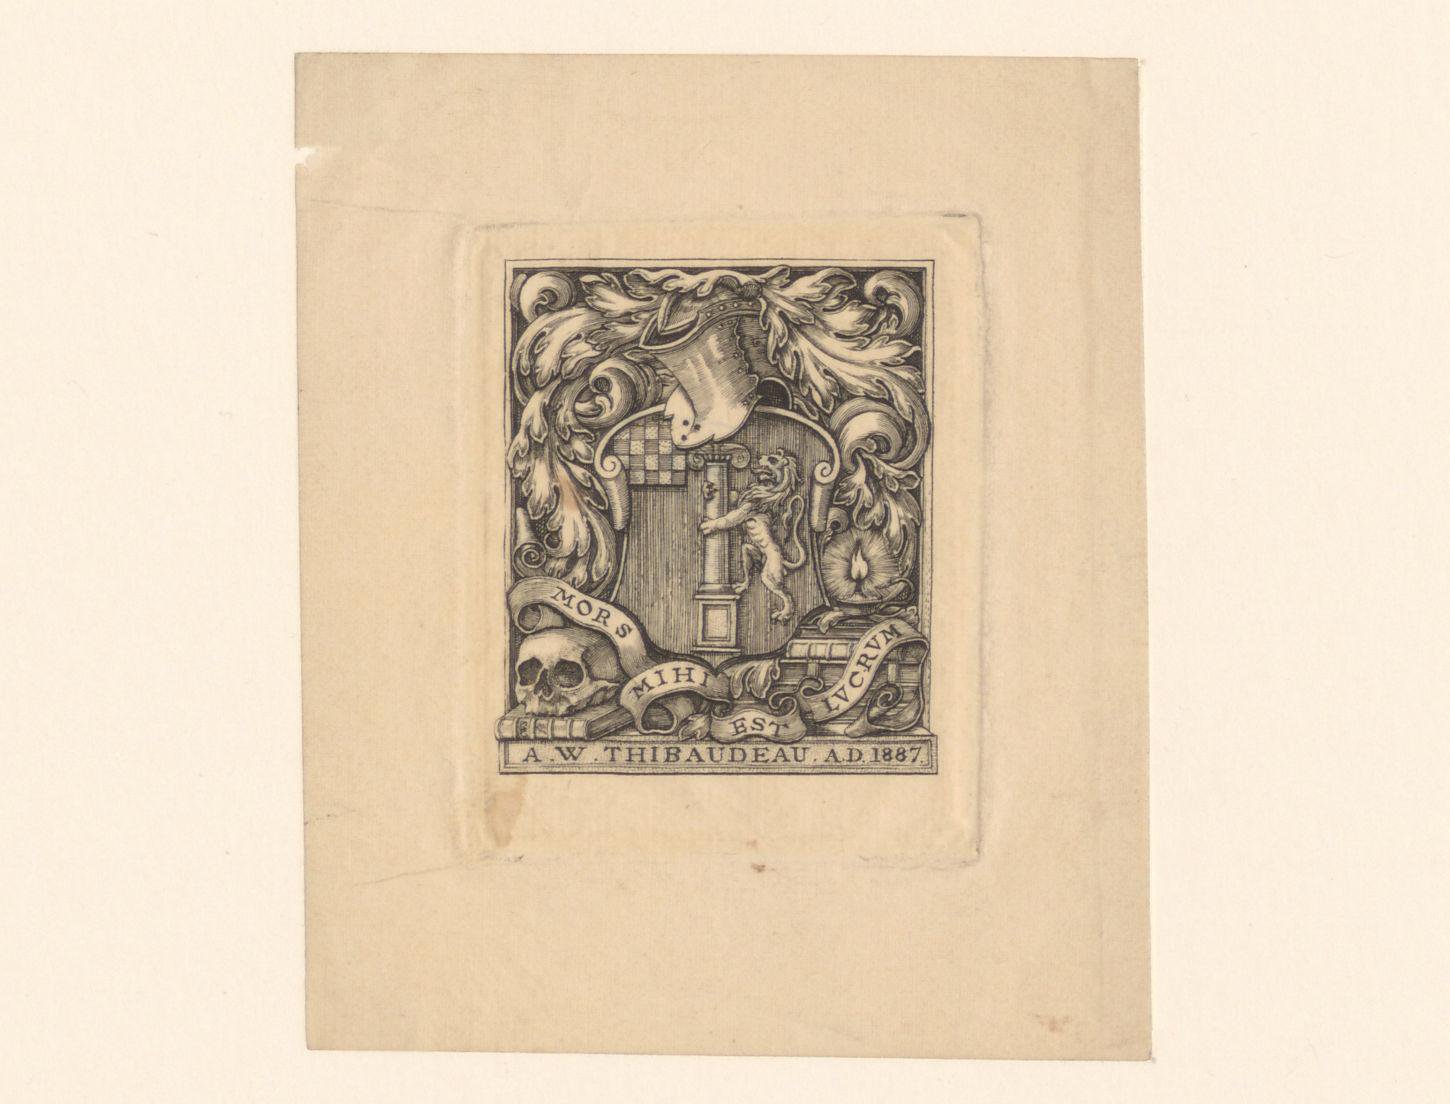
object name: bookplate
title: Ex libris van Alphonse Wyatt Thibaudeau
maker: charles william sherborn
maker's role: print maker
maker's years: 1831-1912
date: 1887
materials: paper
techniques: engraving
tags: foliage ~ ornament, (human) skull, armorial bearing, heraldry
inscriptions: collector's mark: Lugt 2228